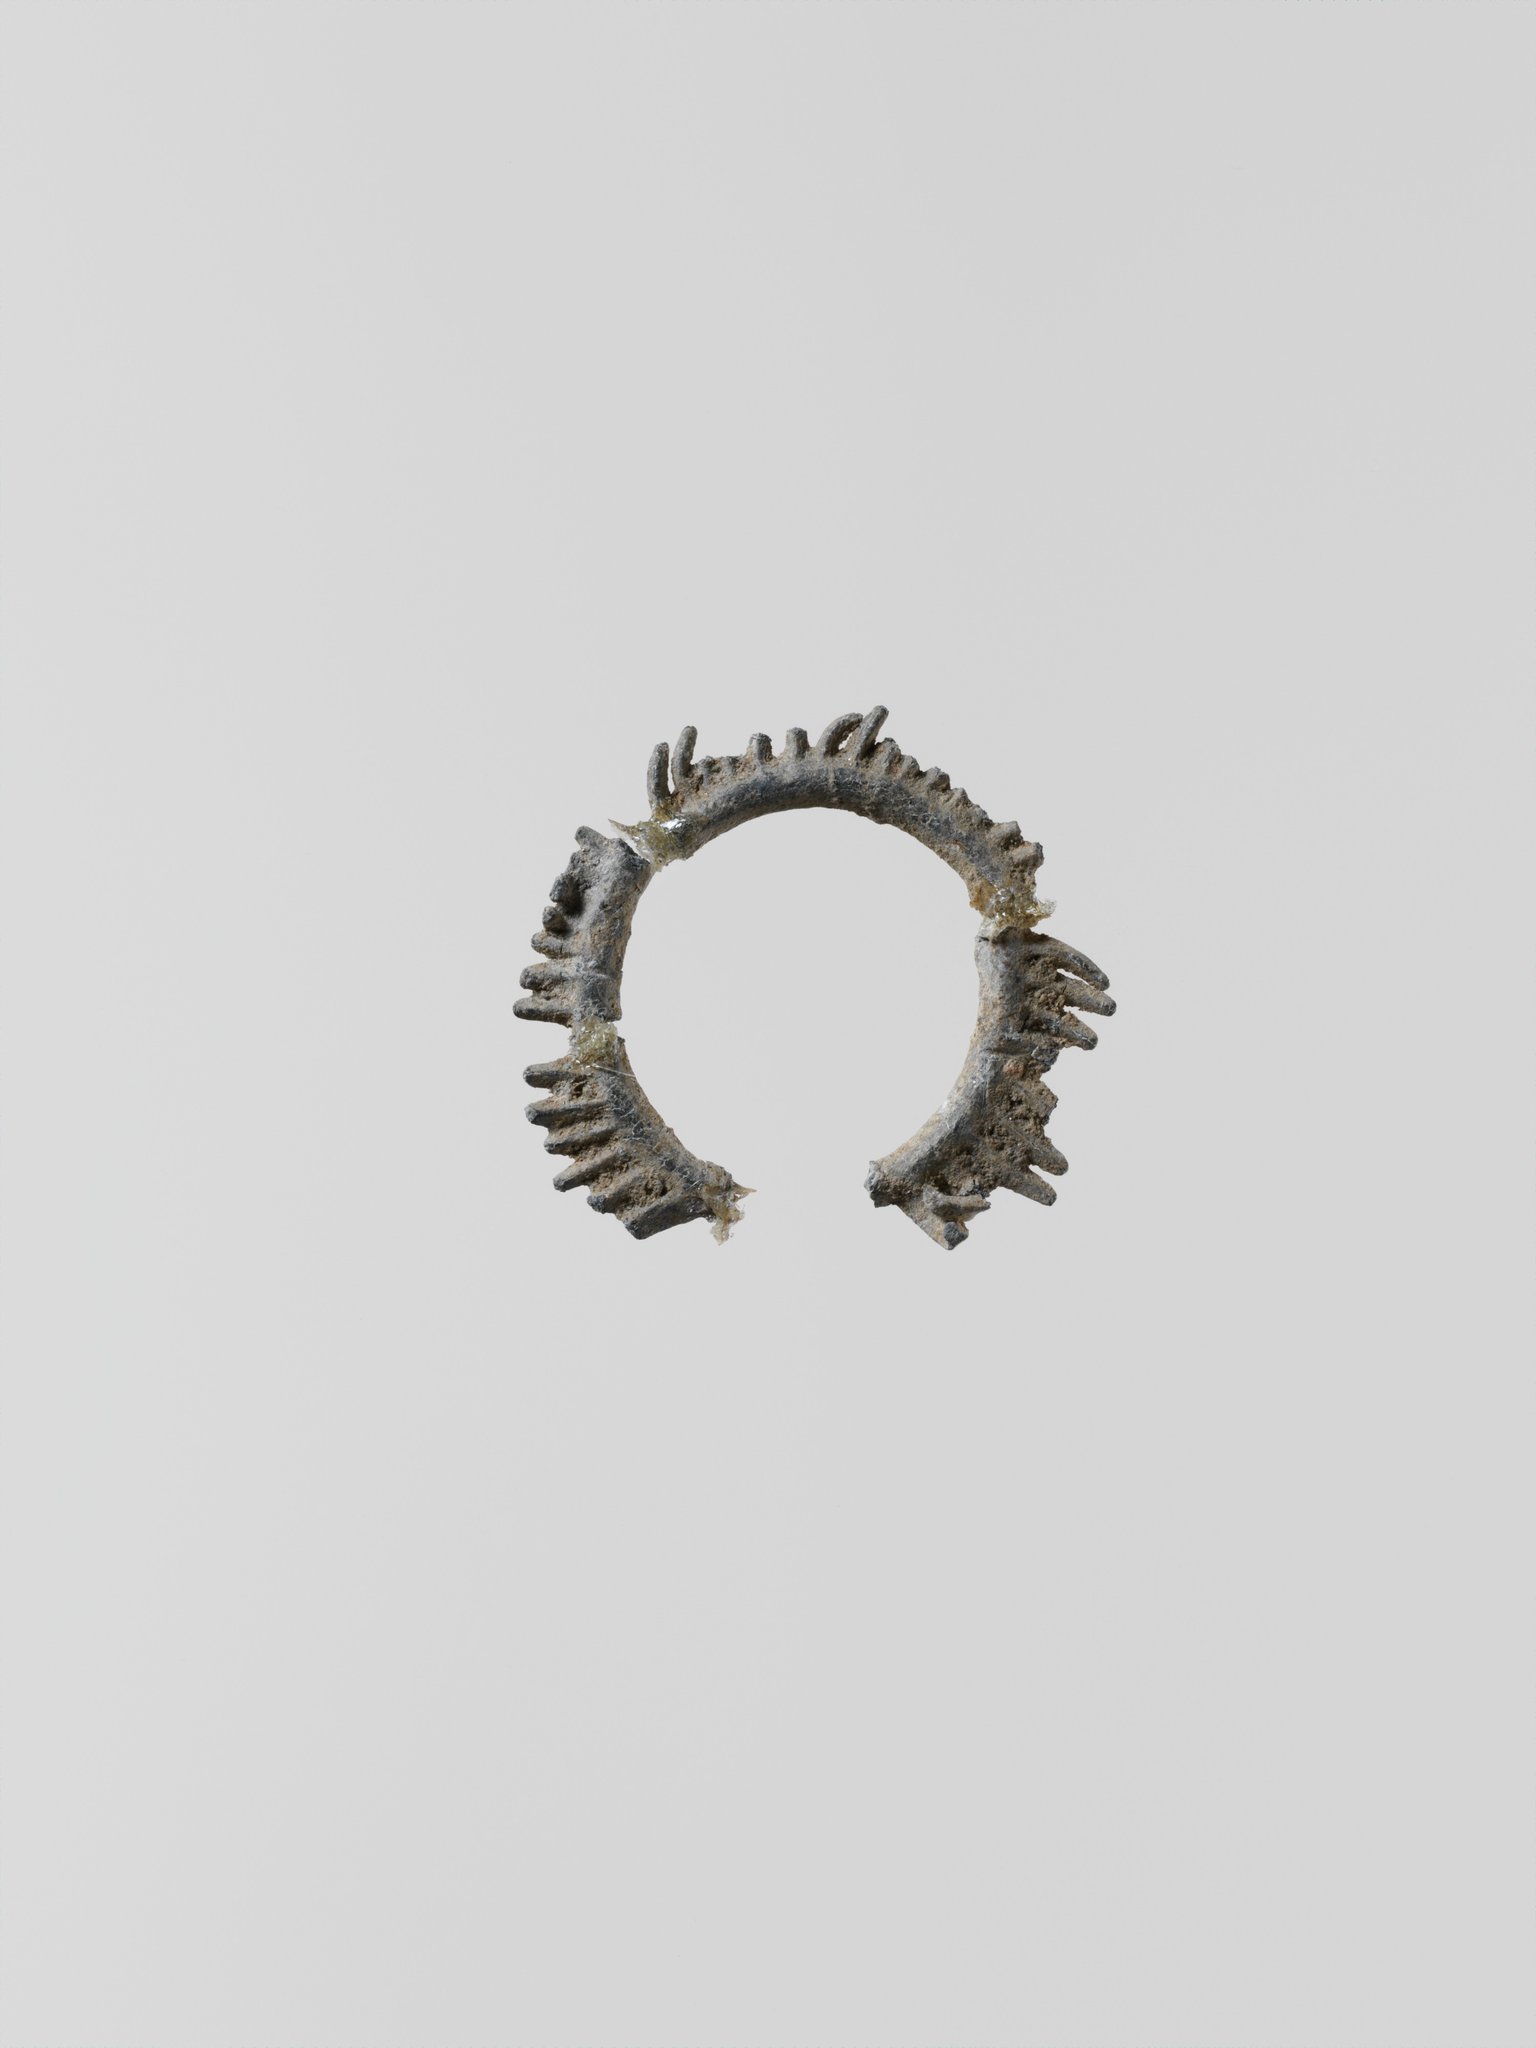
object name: wreath, 11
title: Wreaths, 11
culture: greek, laconian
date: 7000-30 BCE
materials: lead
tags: wreaths